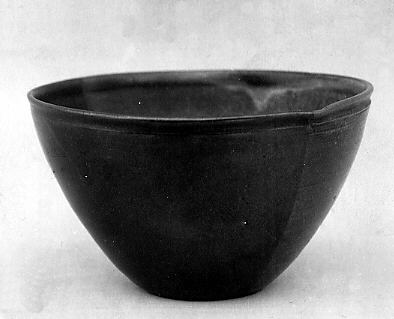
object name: teabowl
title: Small Teabowl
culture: japanese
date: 1701-1800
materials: clay, glaze